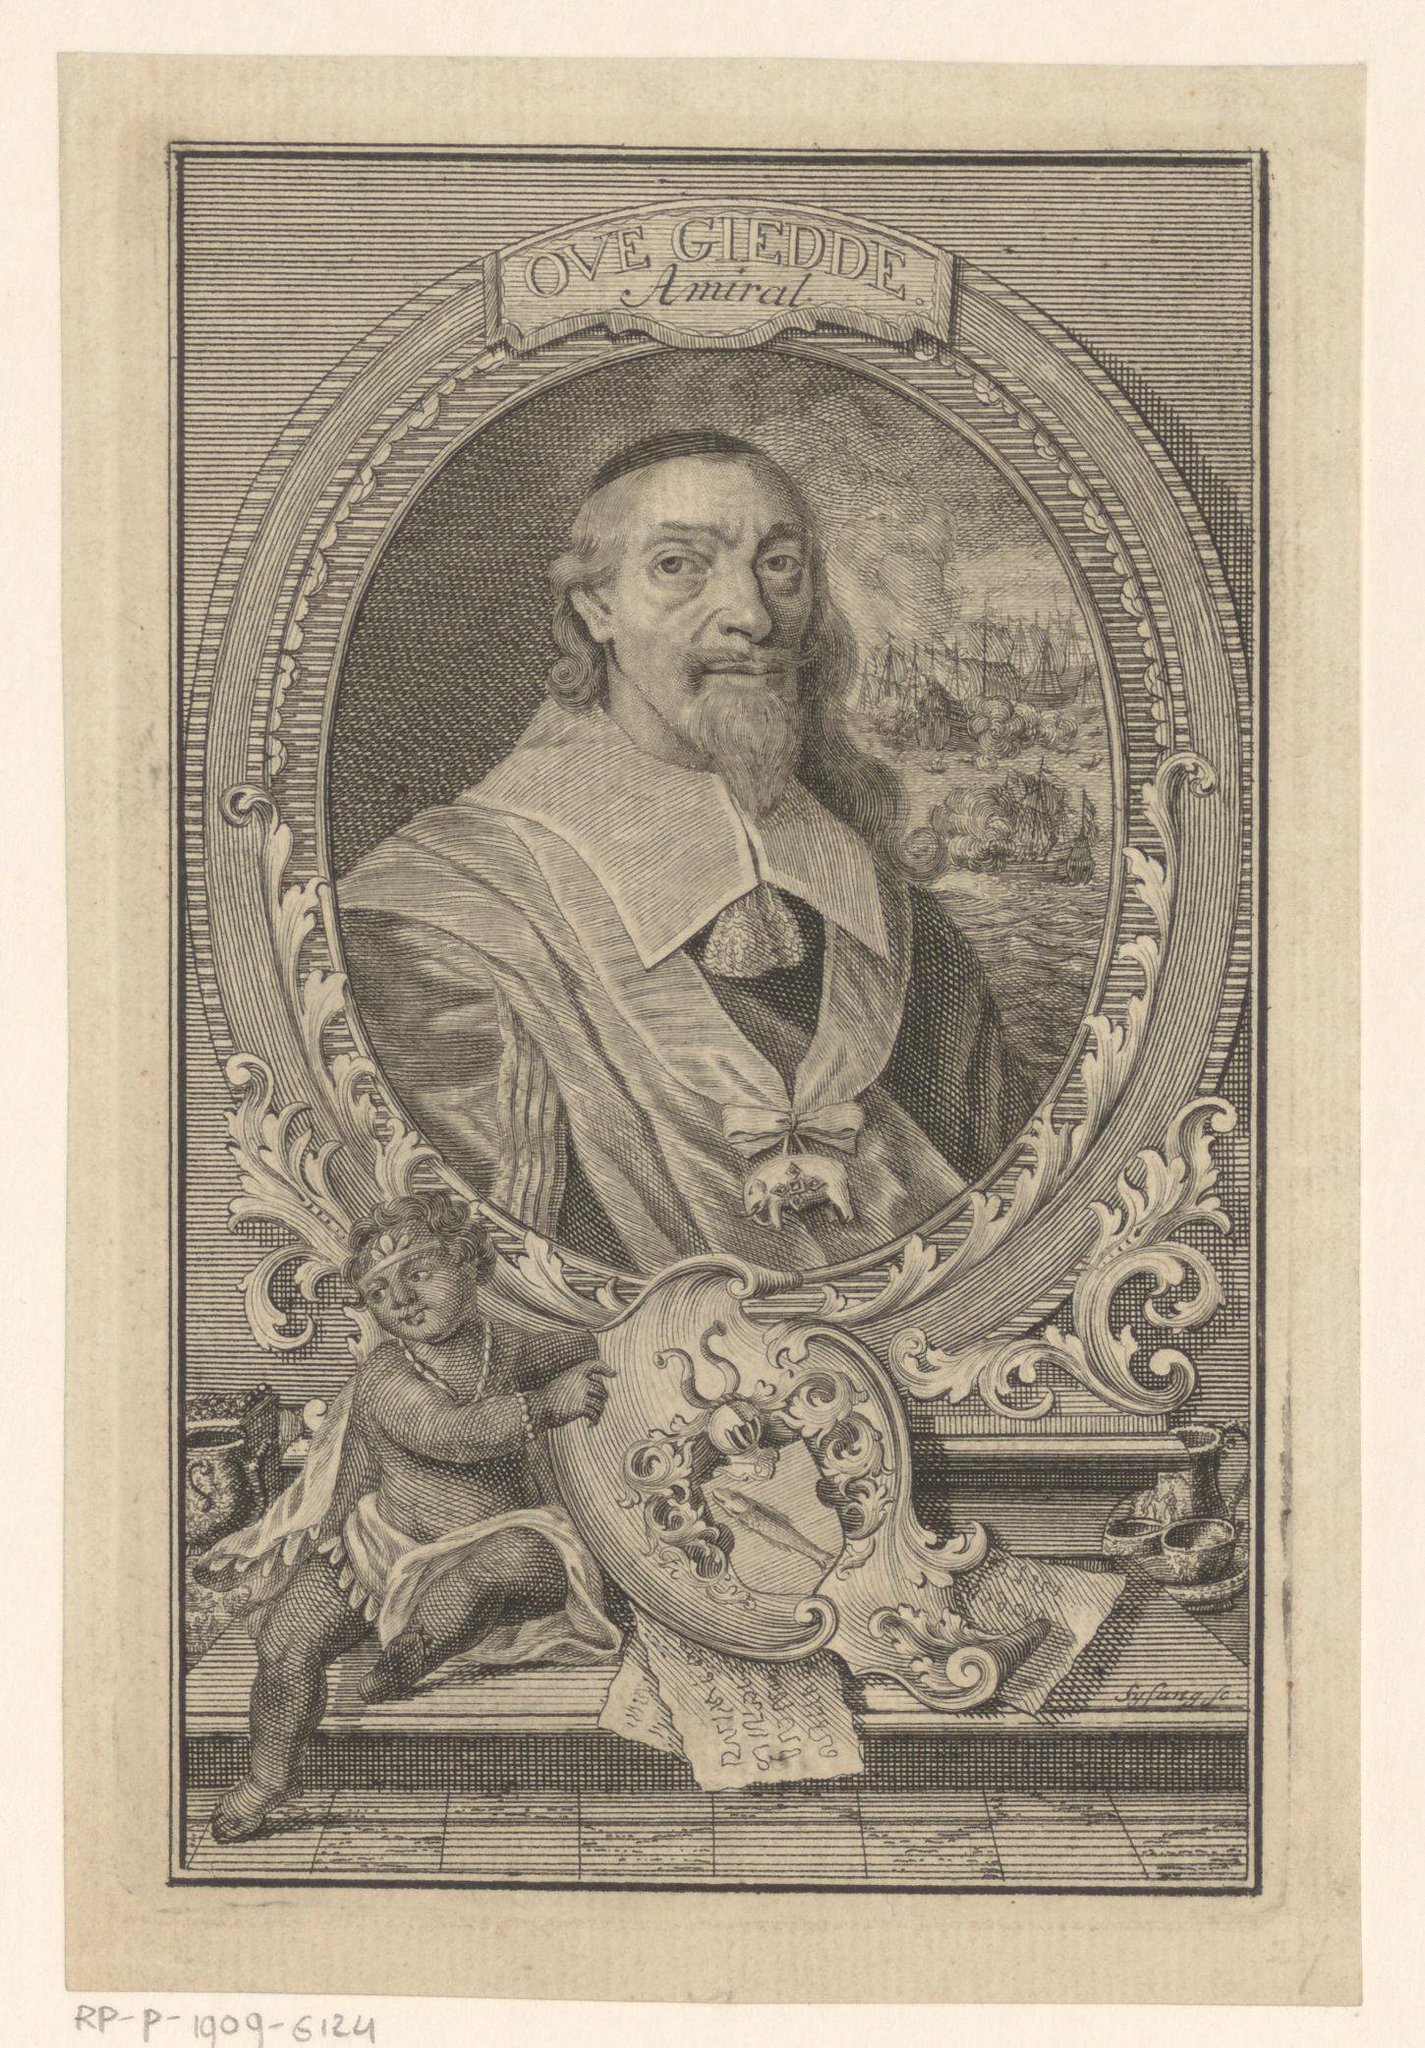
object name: print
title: Portret van Ove Gjedde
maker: johann christoph sysang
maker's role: print maker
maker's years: 1703-1757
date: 1713-1757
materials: paper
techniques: engraving, etching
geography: germany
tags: historical persons, commander-in-chief, admiral, armorial bearing, heraldry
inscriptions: collector's mark: Lugt 2228